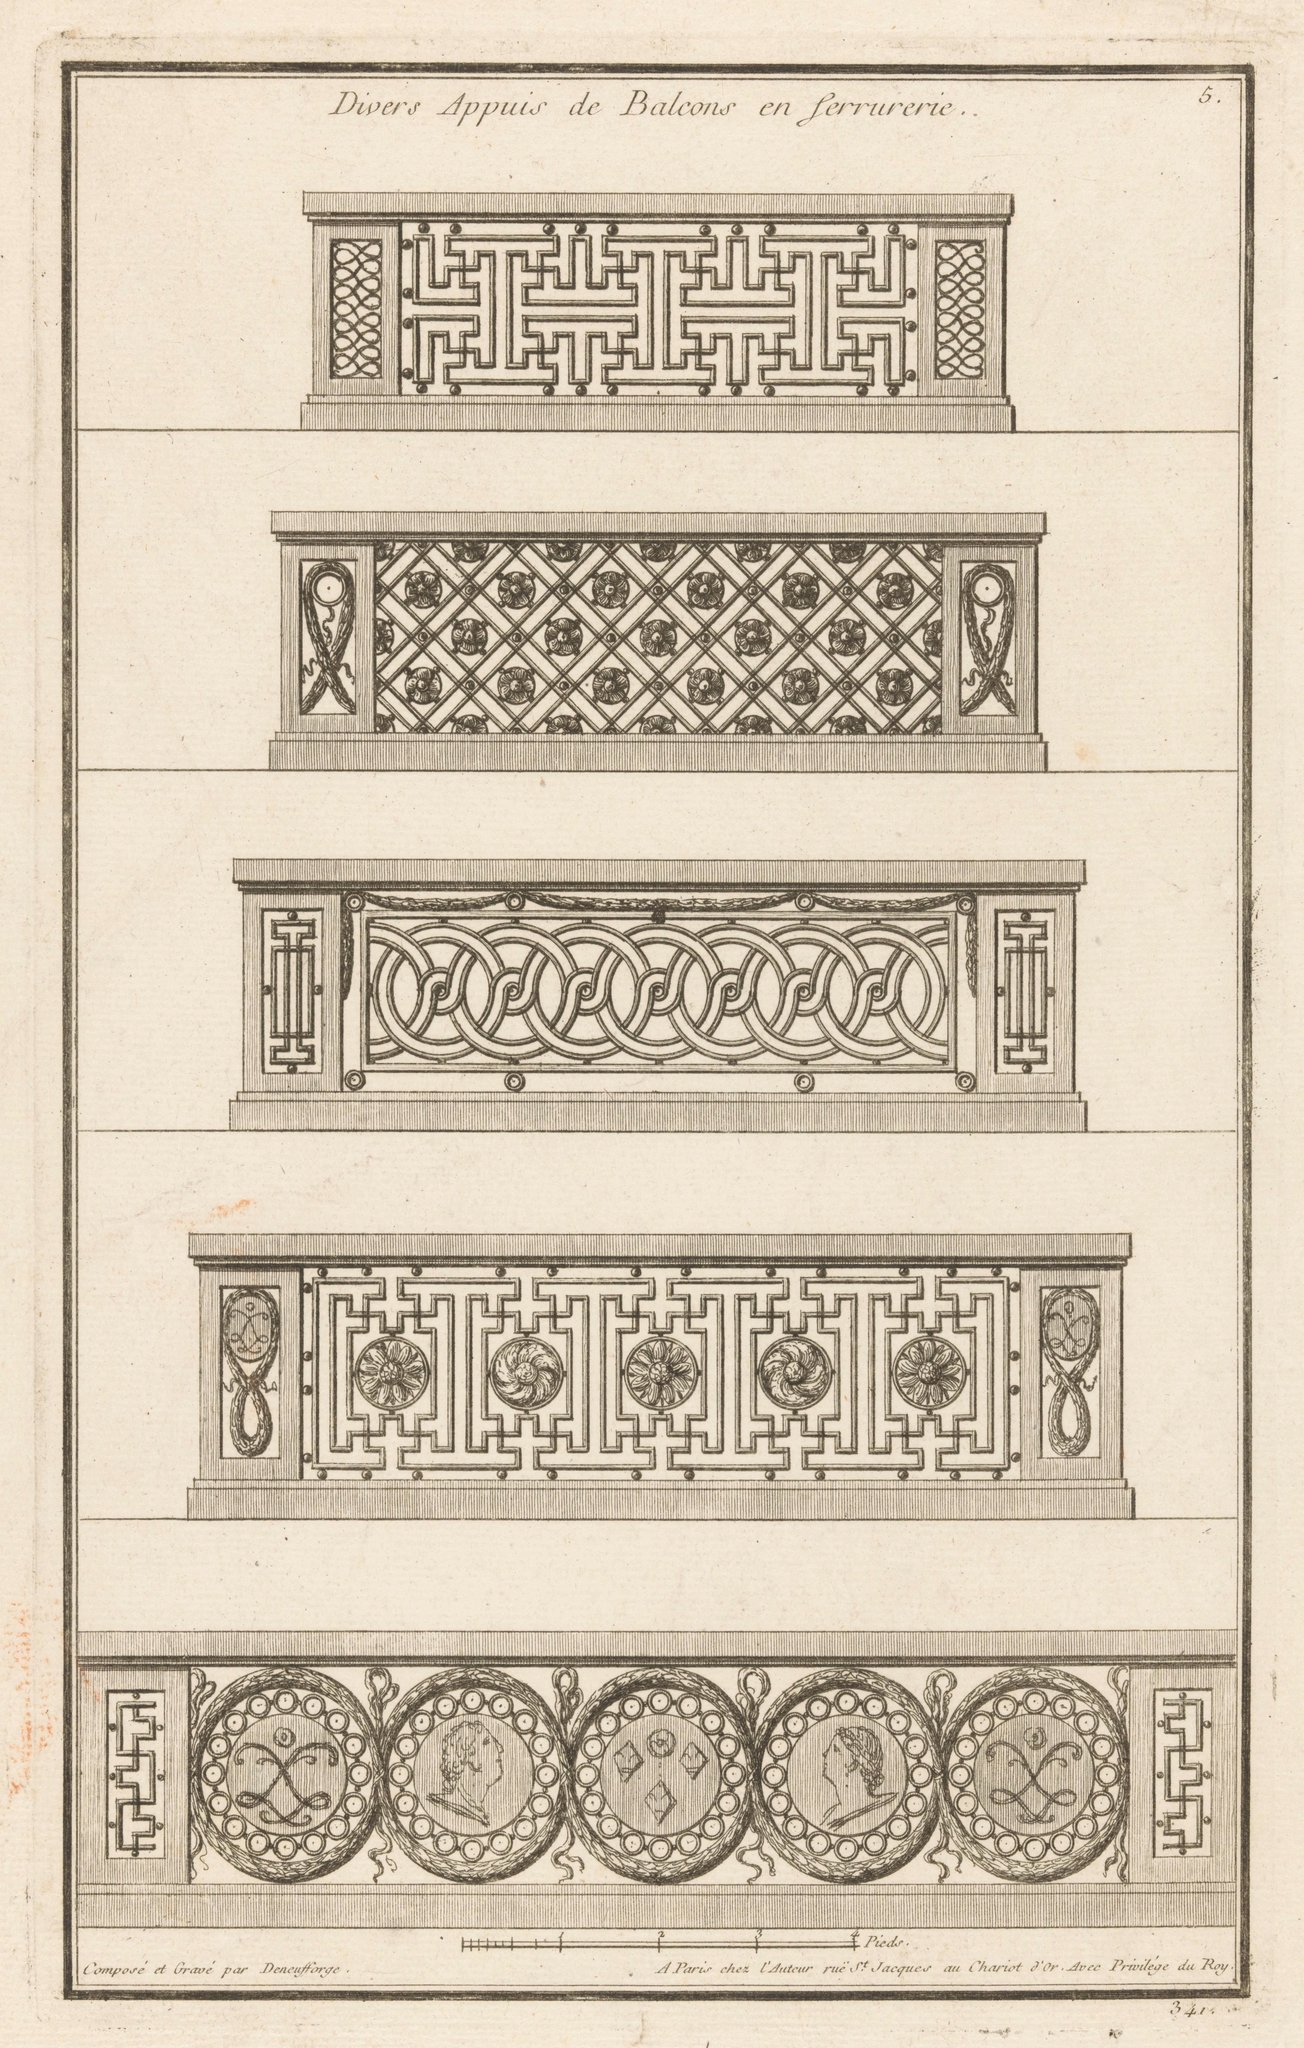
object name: print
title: 57e Cayer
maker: jean françois de neufforge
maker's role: print maker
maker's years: 1714-1791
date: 1763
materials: paper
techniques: etching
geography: paris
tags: balcony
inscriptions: collector's mark: Lugt 2760, collector's mark: Lugt 2228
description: Vijf geornamenteerde smeedijzeren balkonhekken, het onderste hek met medaillons en portretten. Prentnummer 341.